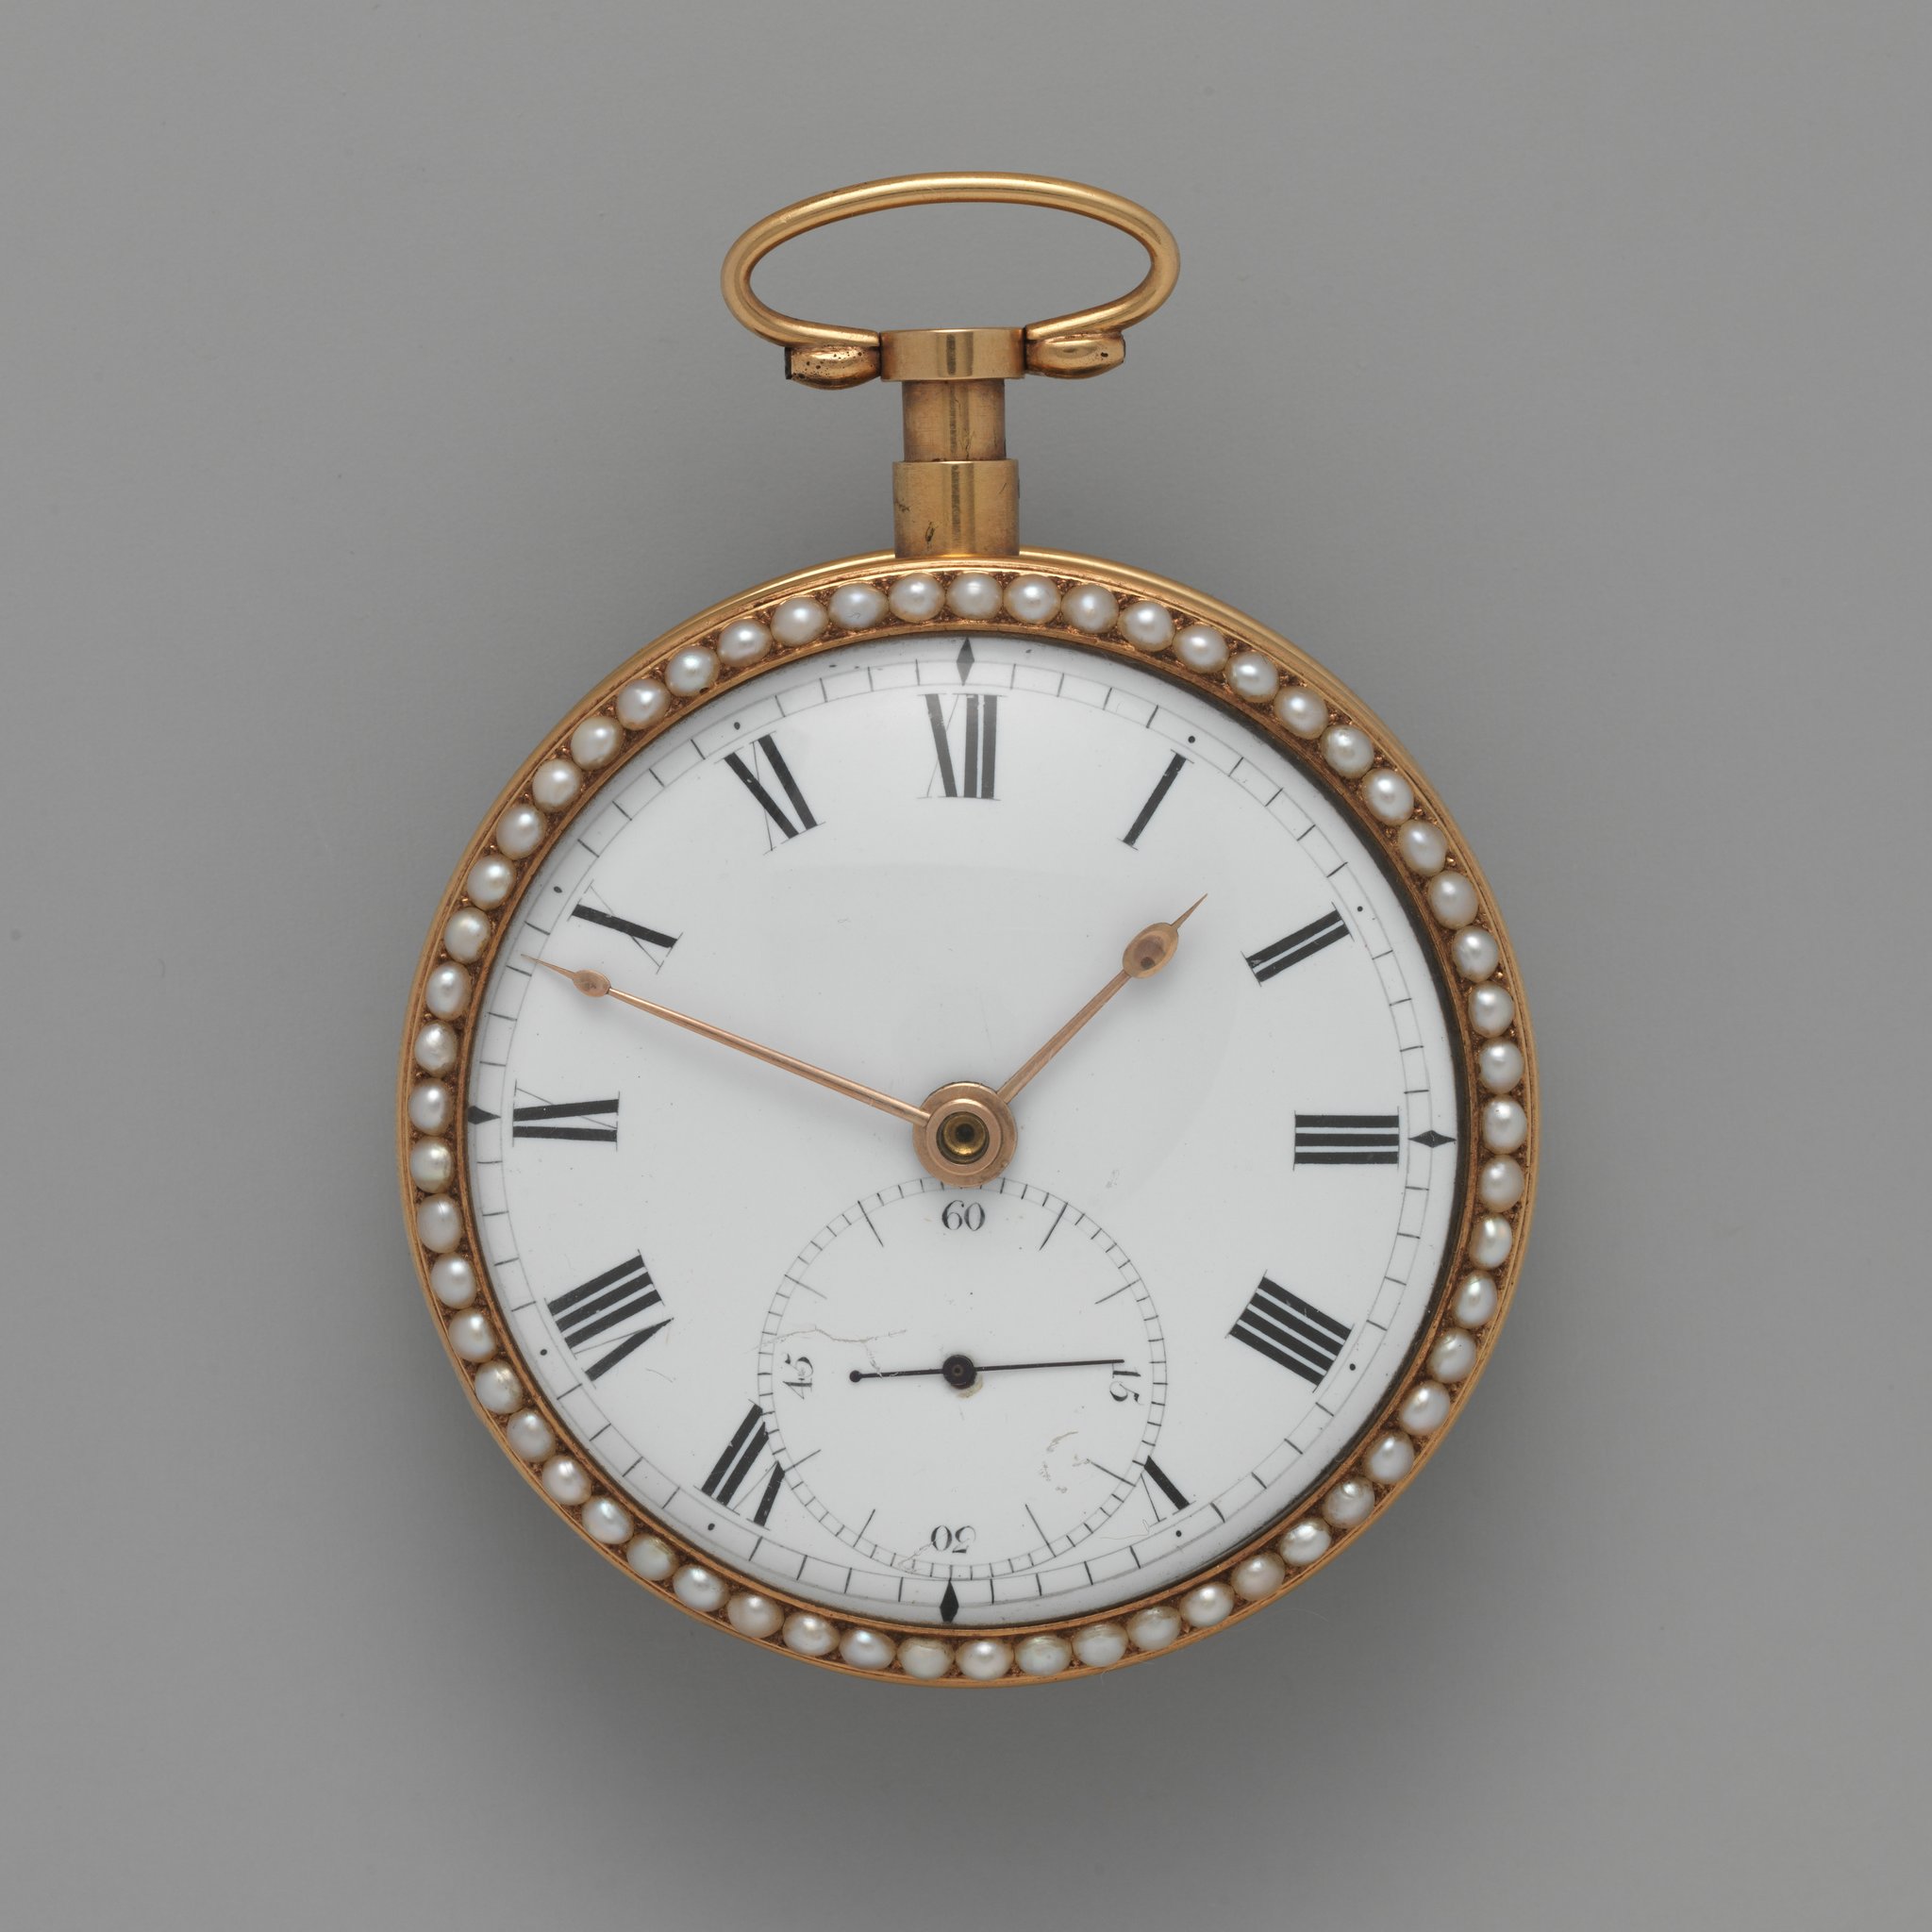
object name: watch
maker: william ilbery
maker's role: maker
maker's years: 1780-1839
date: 1801-1833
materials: diamond, enamel, gold, pearl